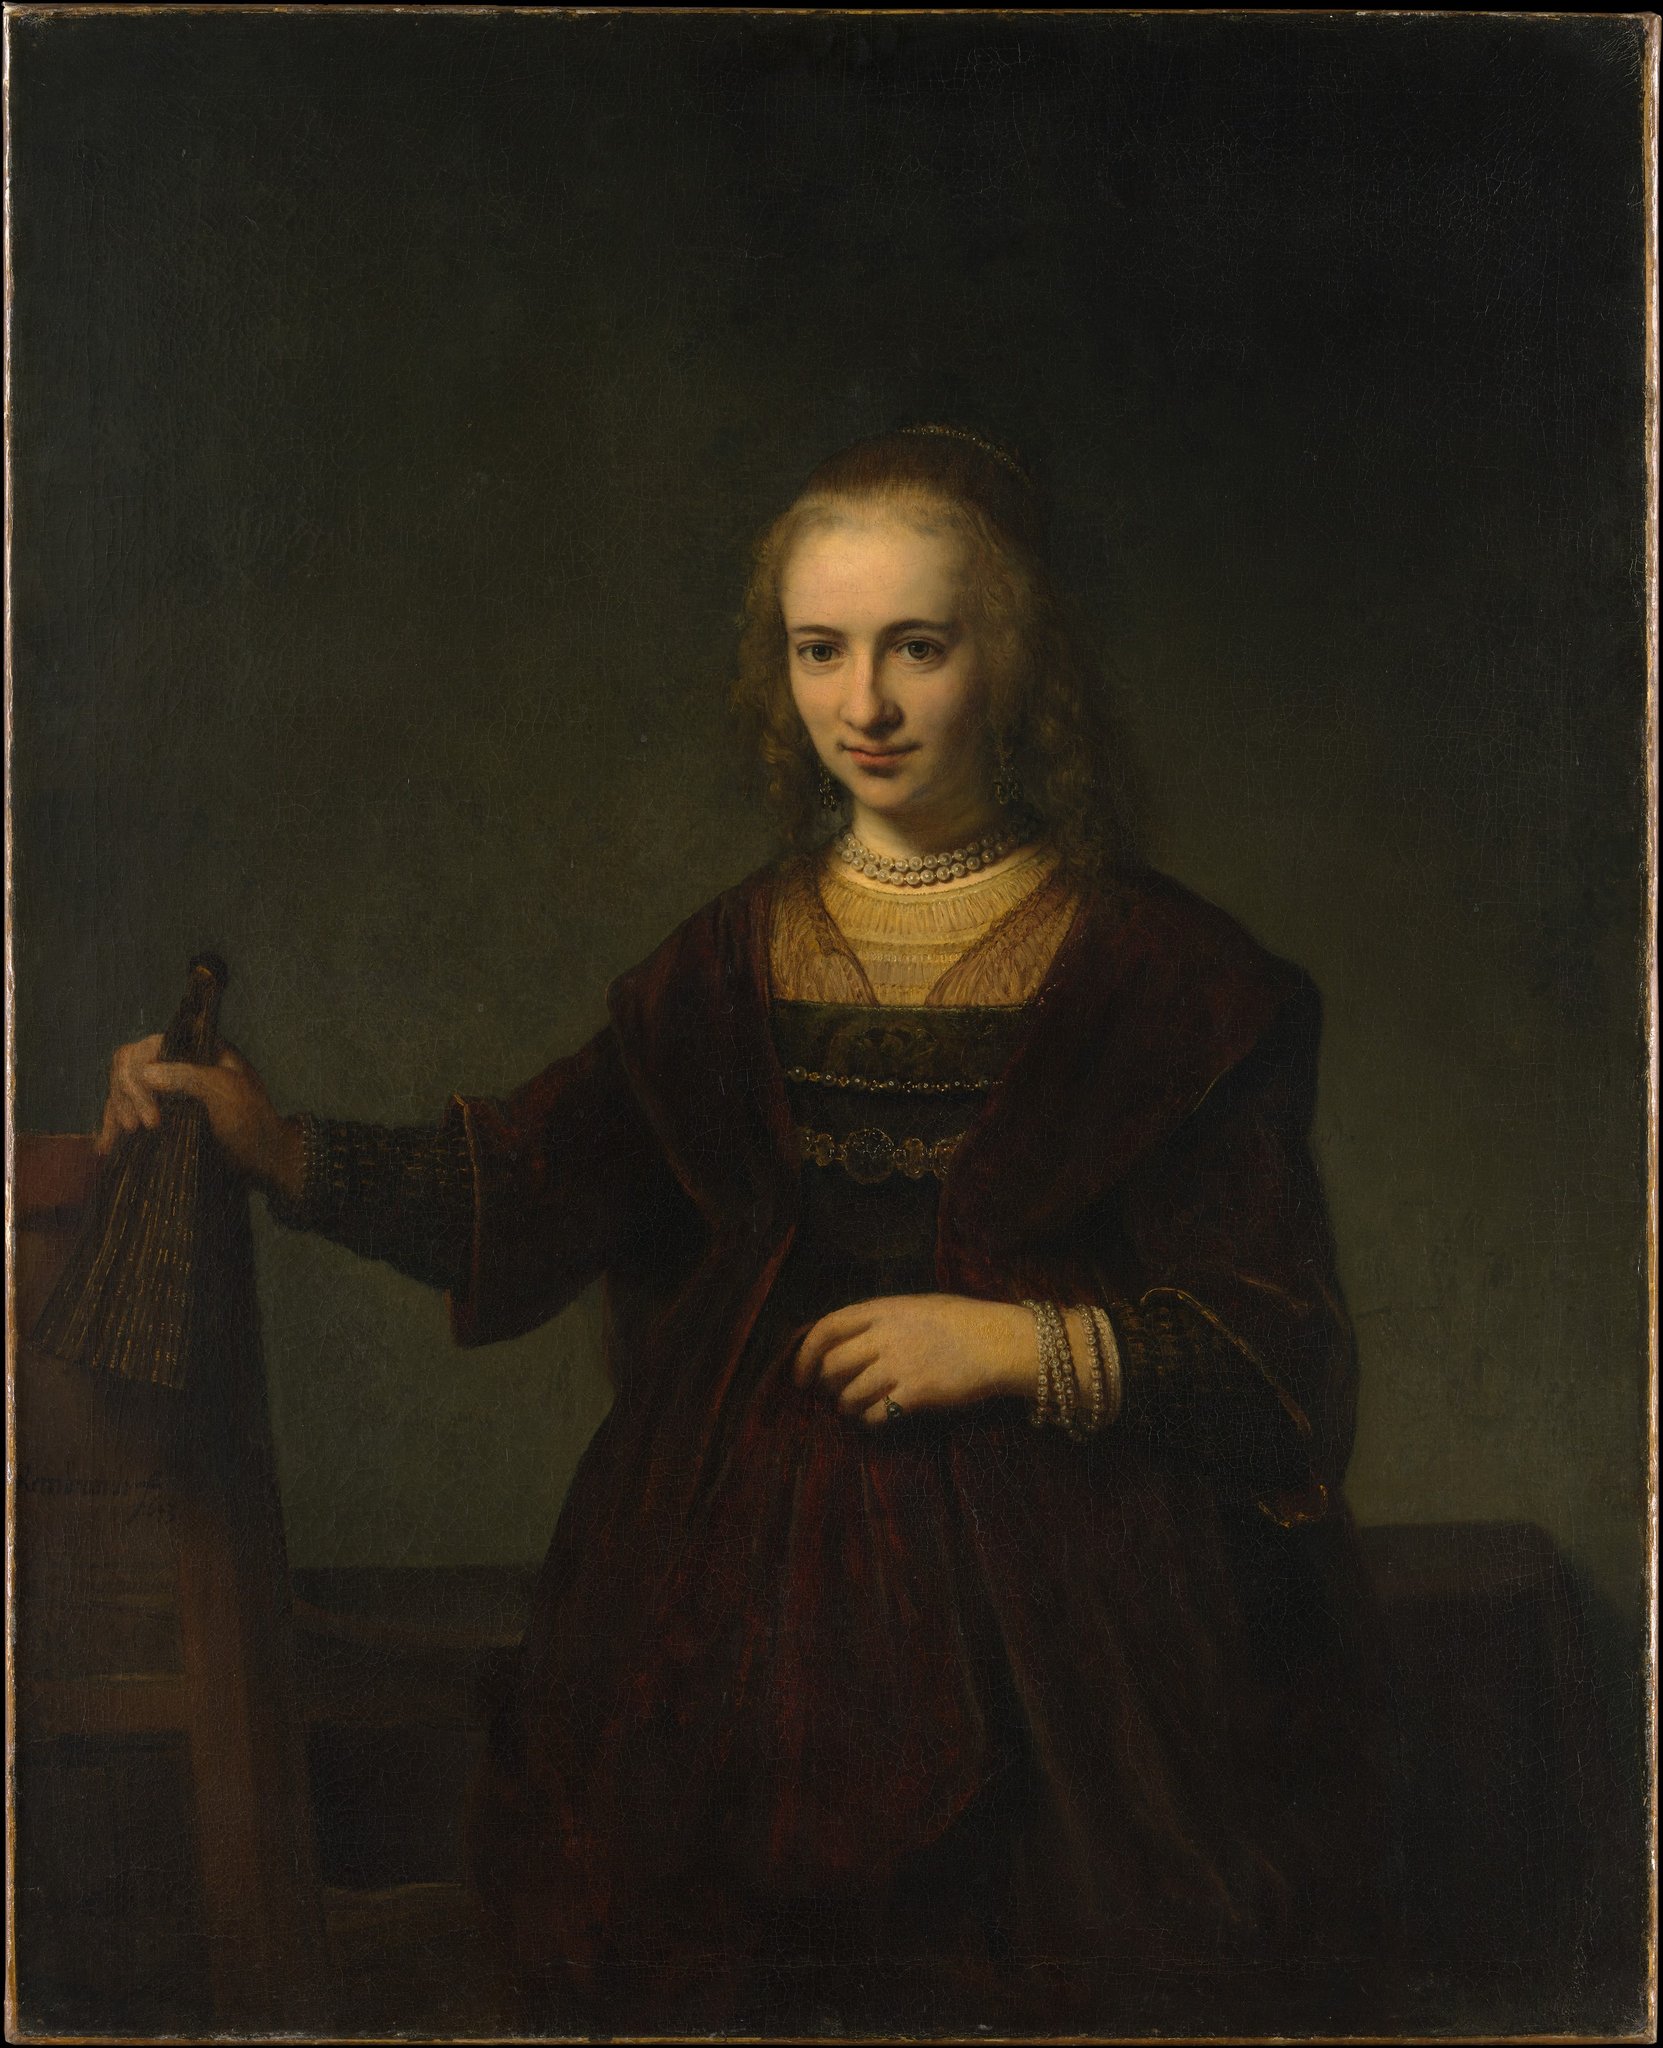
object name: painting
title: Portrait of a Woman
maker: rembrandt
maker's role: artist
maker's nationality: dutch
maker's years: 1606-1669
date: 1625-1674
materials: canvas, oil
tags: portraits,women